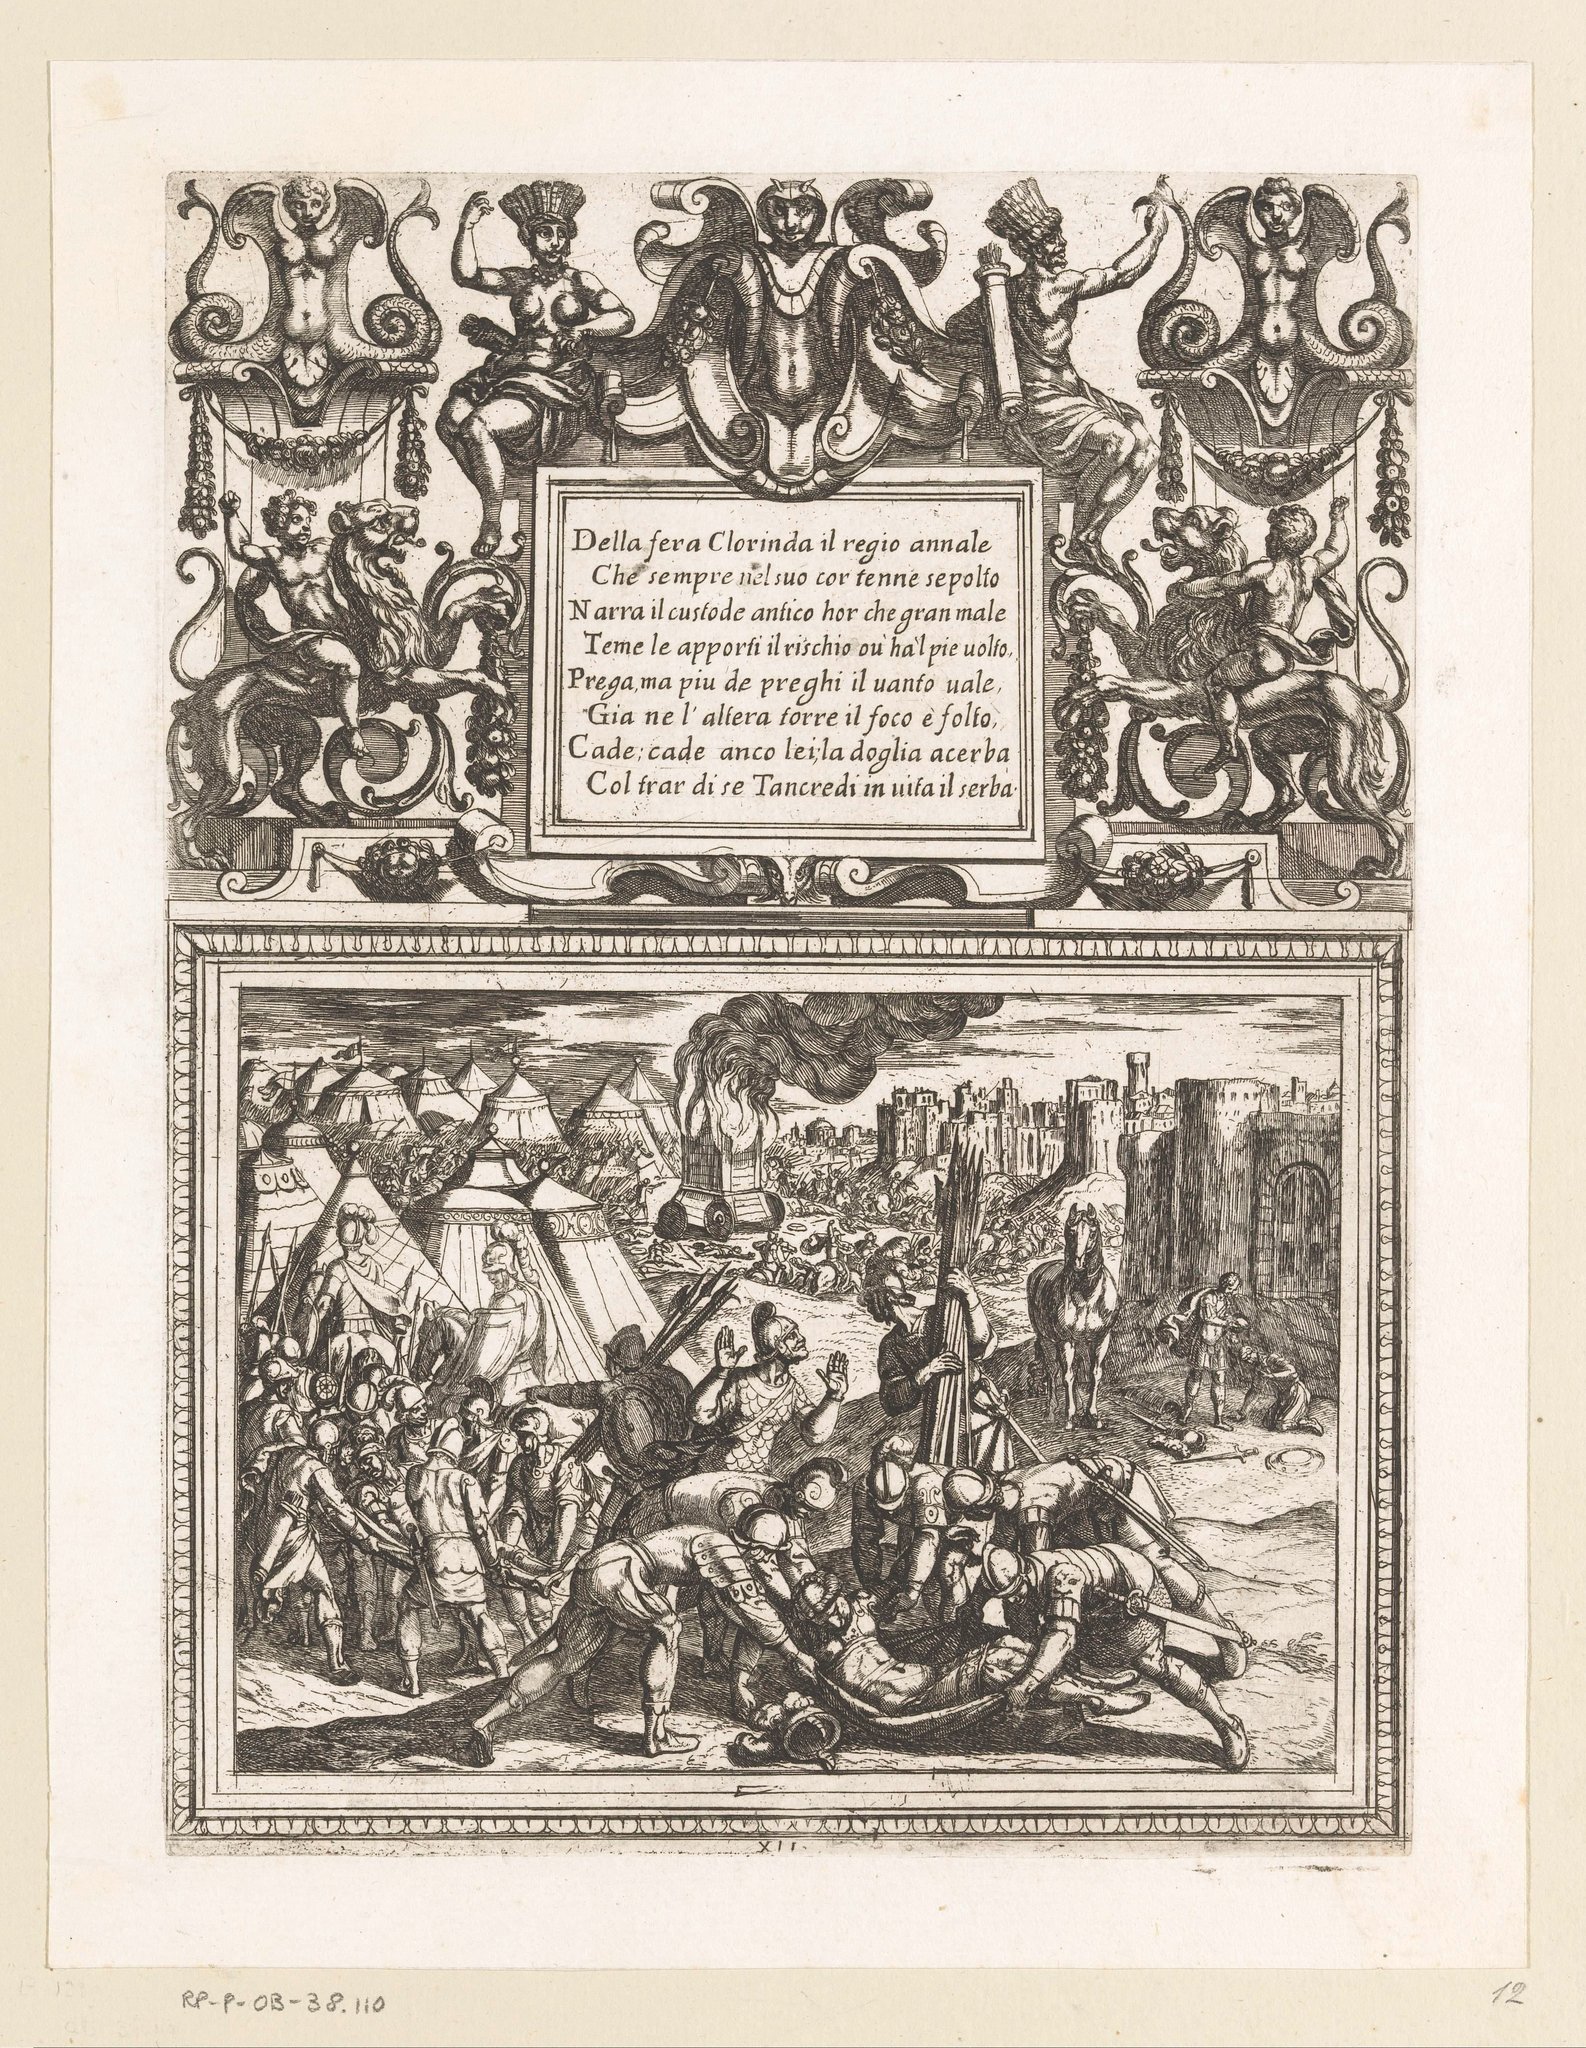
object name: print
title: Jeruzalem verlost (deel 3)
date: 1565-1630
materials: paper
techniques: etching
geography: italy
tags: ornaments ~ art, battle, militant proselytizing: religious war, crusade, etc., ornament ~ cartouche, (scenes from) specific works of literature: tasso, gerusalemme liberata, knight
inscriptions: collector's mark: Lugt 240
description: Deze prent maakt deel uit van een reeks van twintig prenten met ornamentele sierlijsten met daarin voorstellingen van scènes uit Tasso's 'Jeruzalem verlost', een episch gedicht geschreven door de Italiaanse dichter Torquato Tasso en voor het eerst gepubliceerd in 1581. Het verhaal vertelt grotendeels in fictie over de Eerste Kruistocht waarin de christenen, geleid door Godfried van Bouillon, de strijd aangaan met de moslims om het Beleg van Jeruzalem.